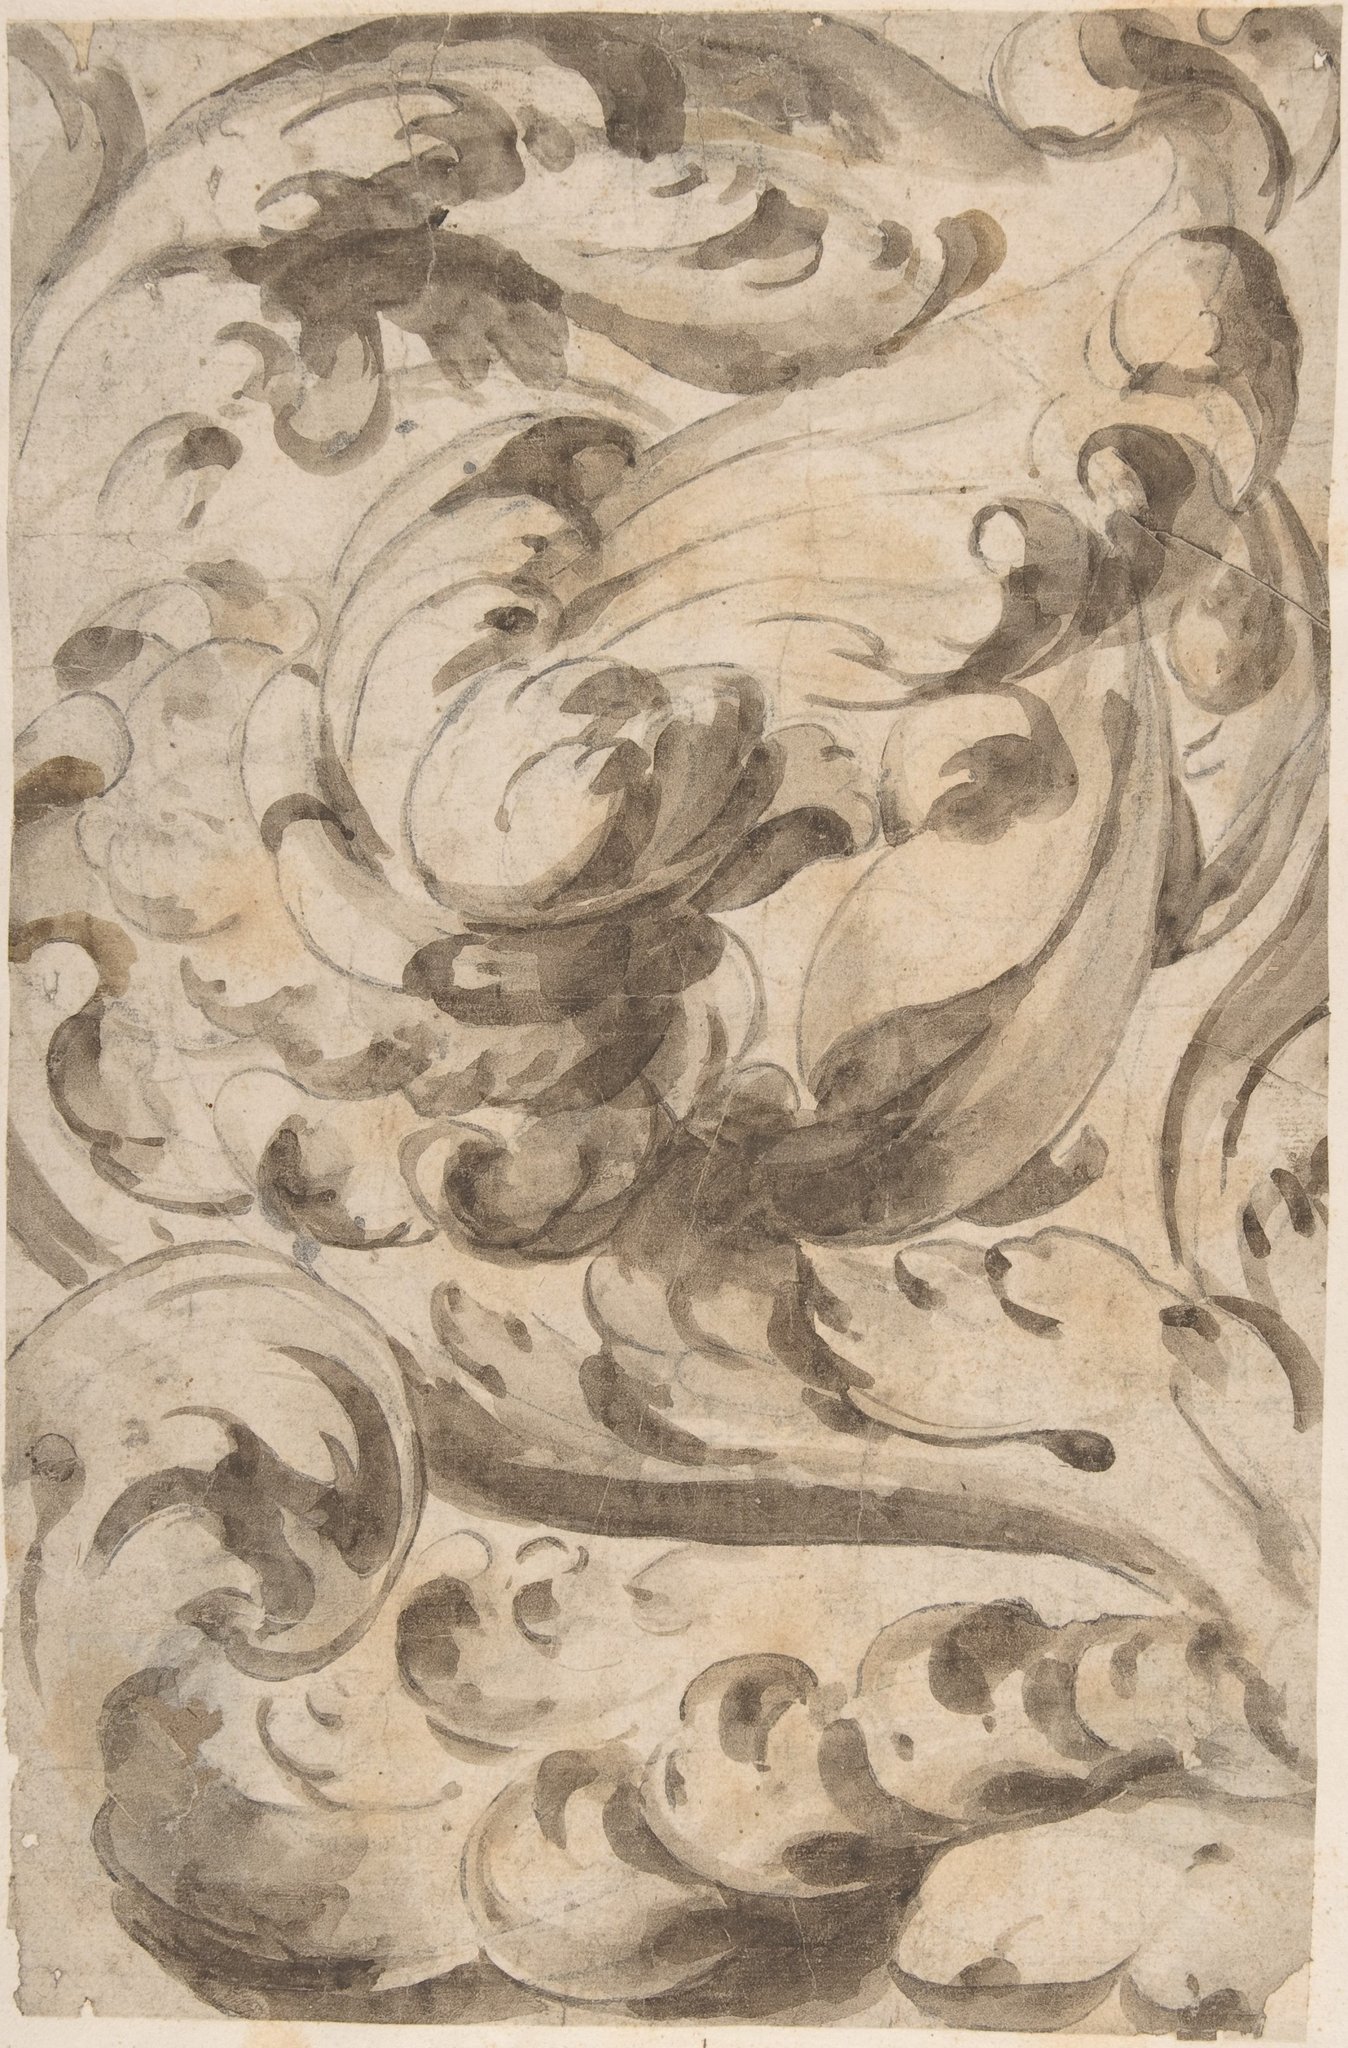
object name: drawing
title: Overall Pattern of Acanthus Scrolls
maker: anonymous, italian, 17th century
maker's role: artist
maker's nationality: italian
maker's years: 1600-1700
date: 1601-1700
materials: graphite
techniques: brush, wash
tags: scrolls,acanthus